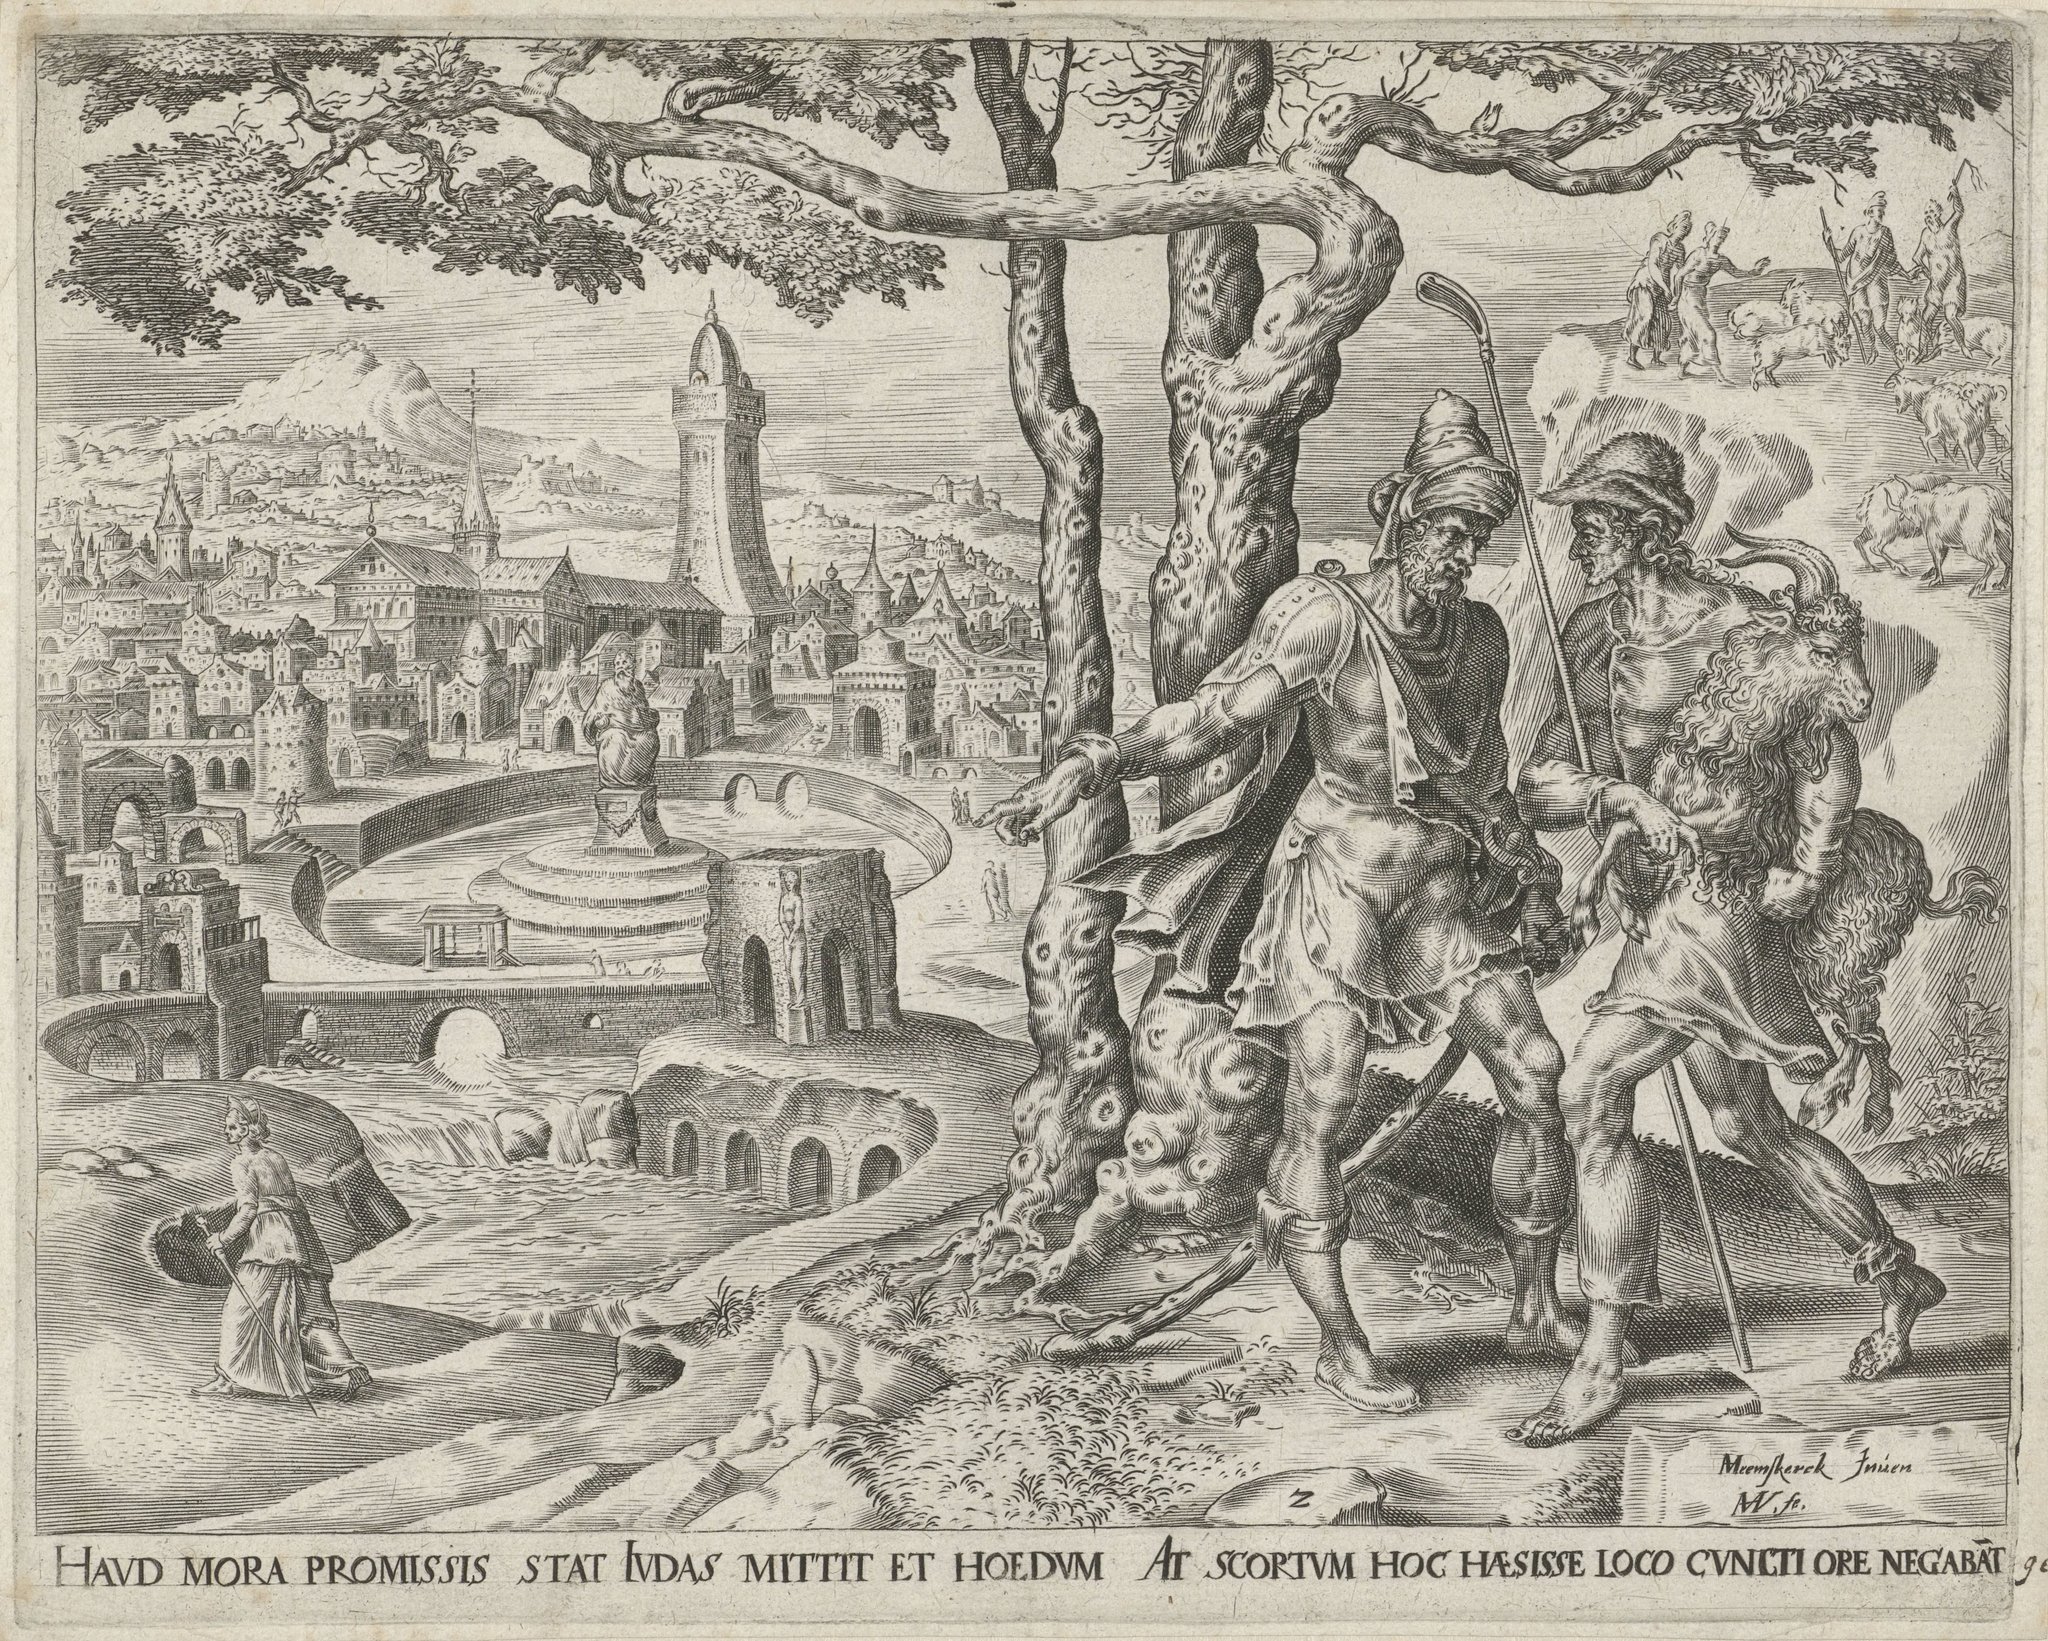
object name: print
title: Geschiedenis van Juda en Tamar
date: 1564-1568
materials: paper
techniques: engraving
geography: amsterdam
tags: hirah with the promised kid of judah, looking in vain for tamar, tamar returns home (with the tokens from judah)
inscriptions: collector's mark: Lugt 2228, collector's mark: Lugt 2760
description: Juda geeft zijn vriend Chira de opdracht om een geitenbokje als betaling aan de prostituee te geven, terwijl hij op de vertrekkende Tamar wijst. Chira houdt het bokje onder de arm en zal de prostituee gaan zoeken, maar niet vinden. Onderaan in de marge een vers in het Latijn.